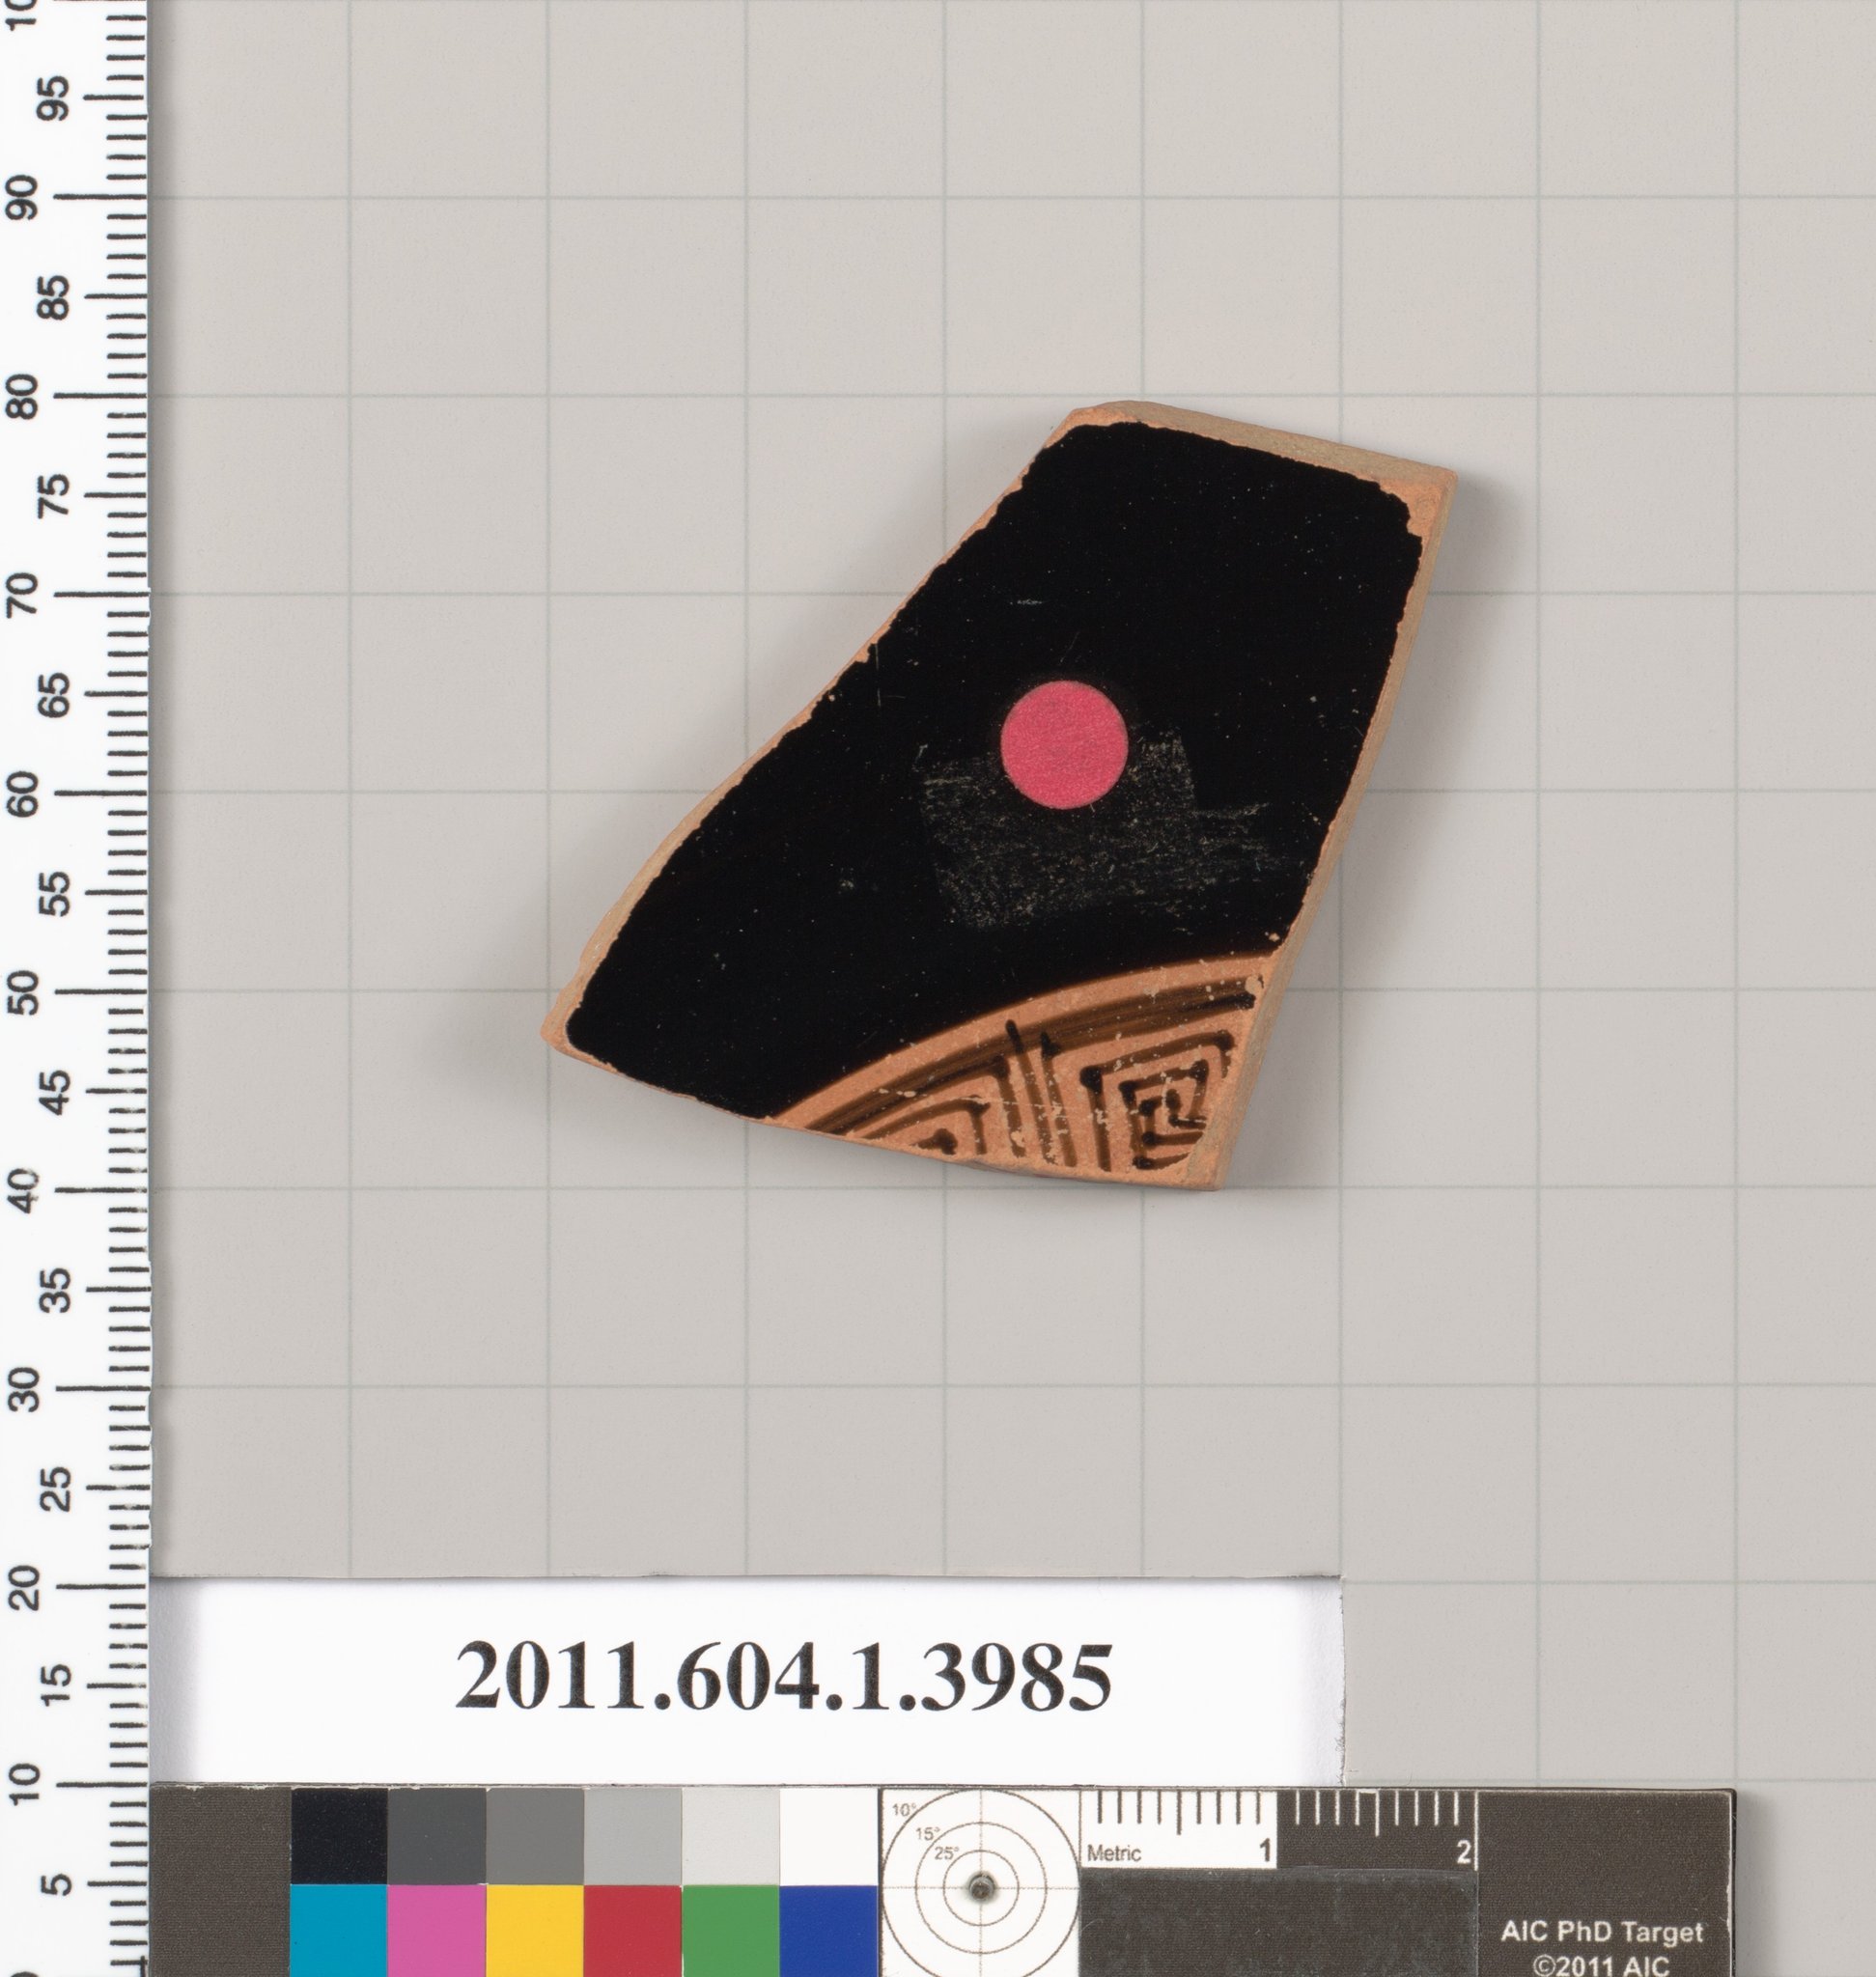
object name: kylix fragment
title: Terracotta fragment of a kylix (drinking cup)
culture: greek, attic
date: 475-451 BCE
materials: terracotta